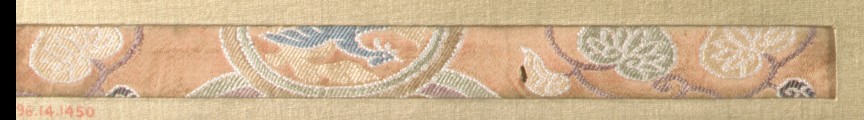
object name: piece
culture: japanese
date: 1701-1900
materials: silk